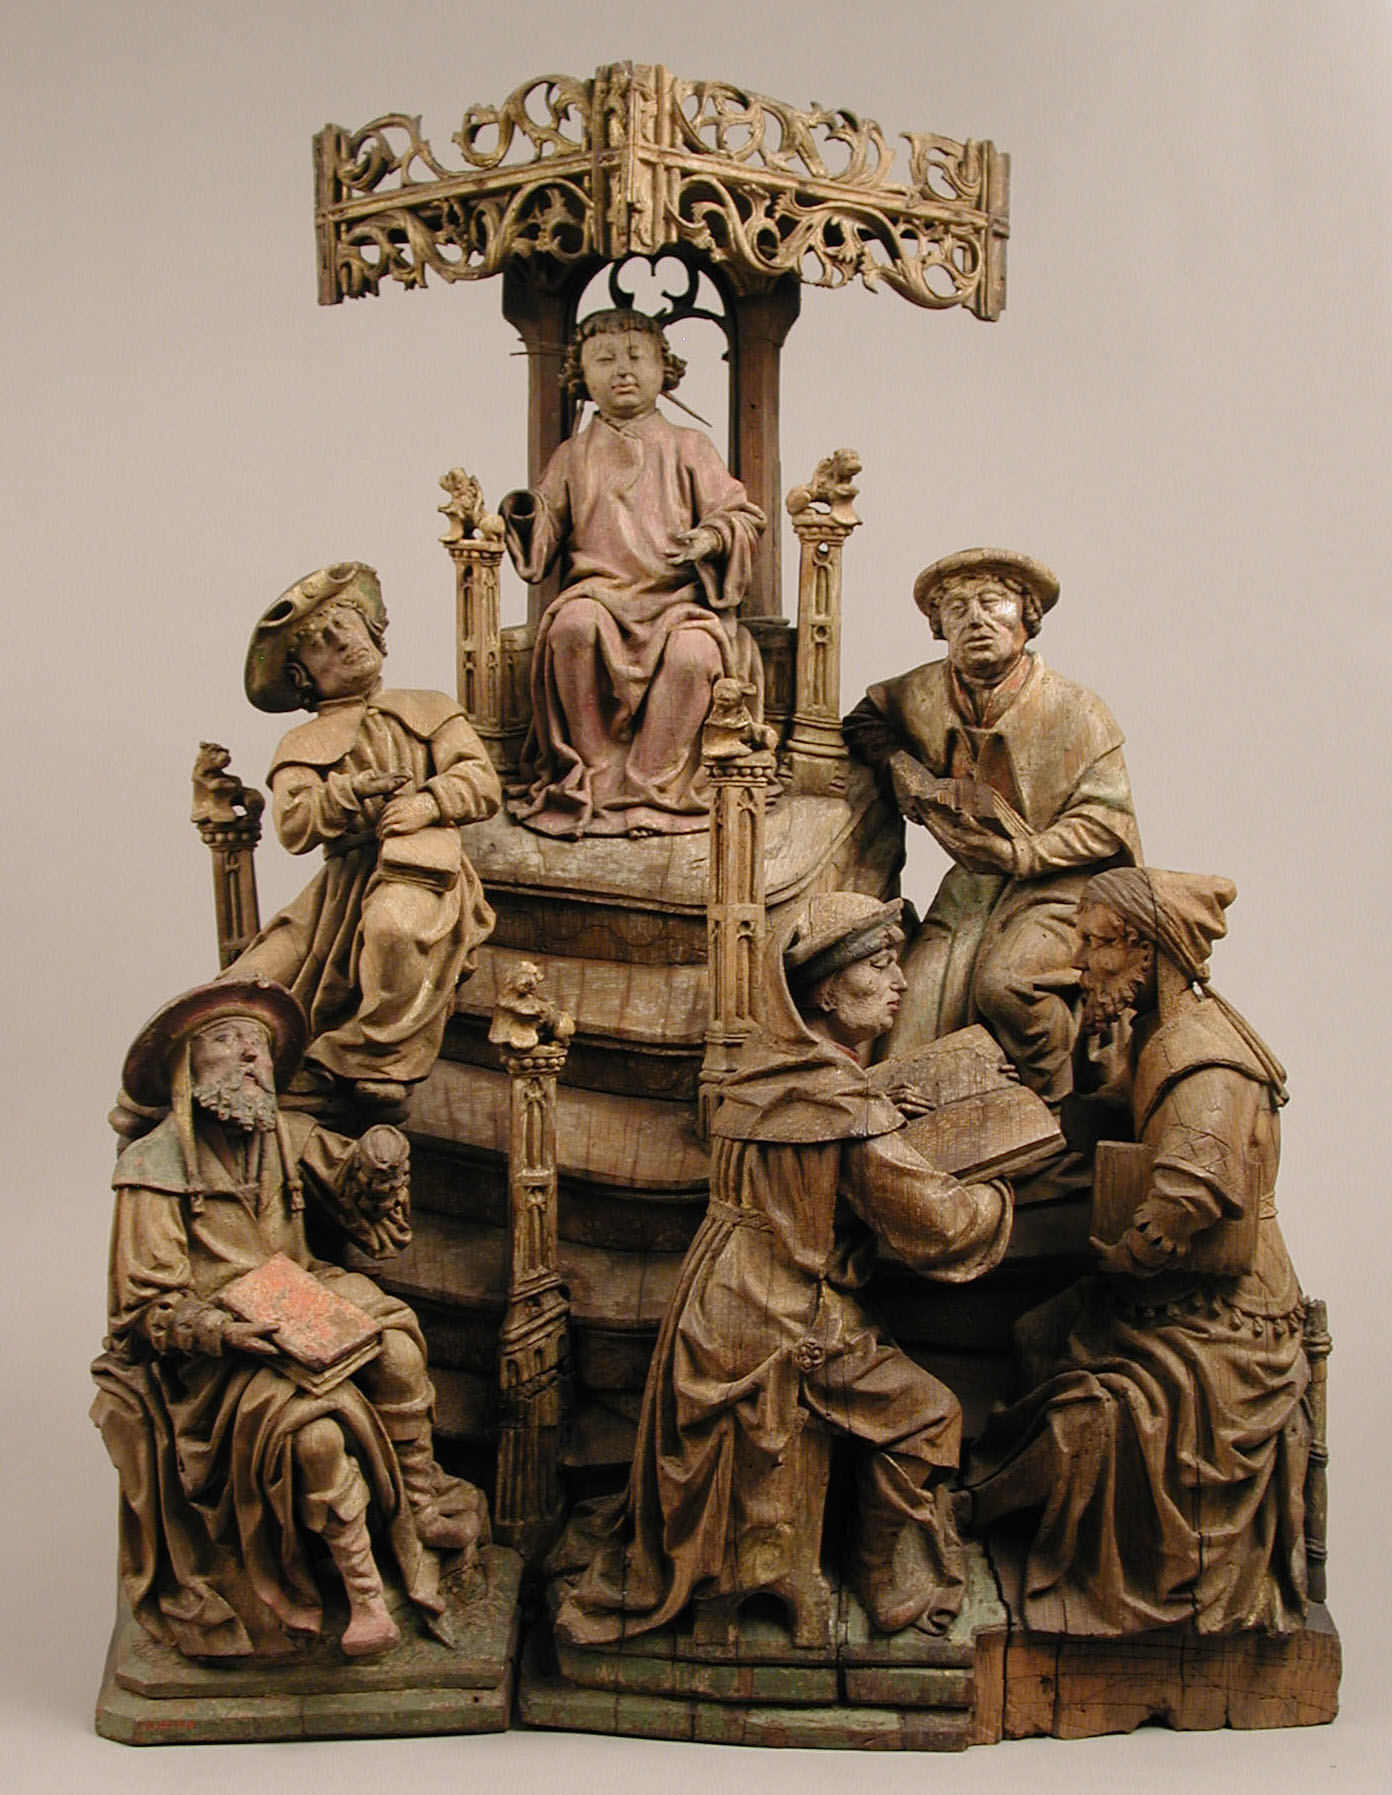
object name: relief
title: Christ among the Doctors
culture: german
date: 1501-1533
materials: gilt, wood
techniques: polychromy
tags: men,christ,doctors